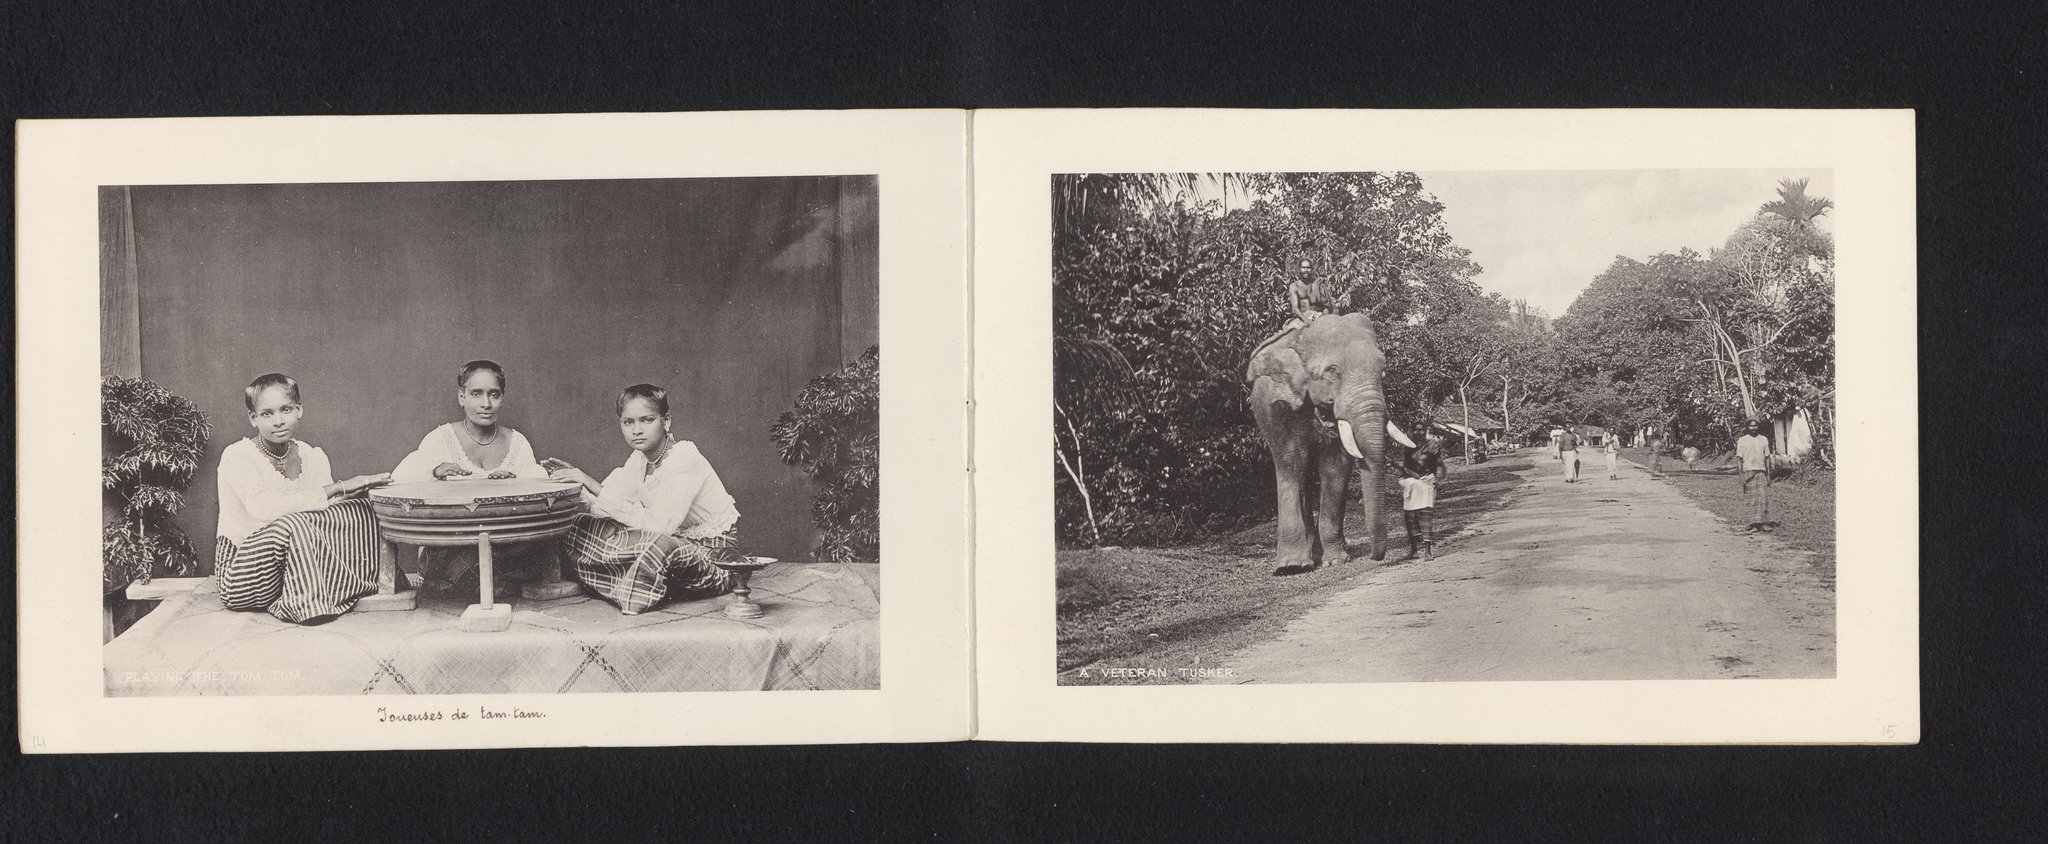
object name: page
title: Gezicht op drie vrouwen die de tam tam bespelen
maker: henry william cave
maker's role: fotograaf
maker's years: 1854-1913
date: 1890-1910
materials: paper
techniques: photograph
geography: colombo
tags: adult woman, percussion instruments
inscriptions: inscription: ‘Joueuses de tam tam’